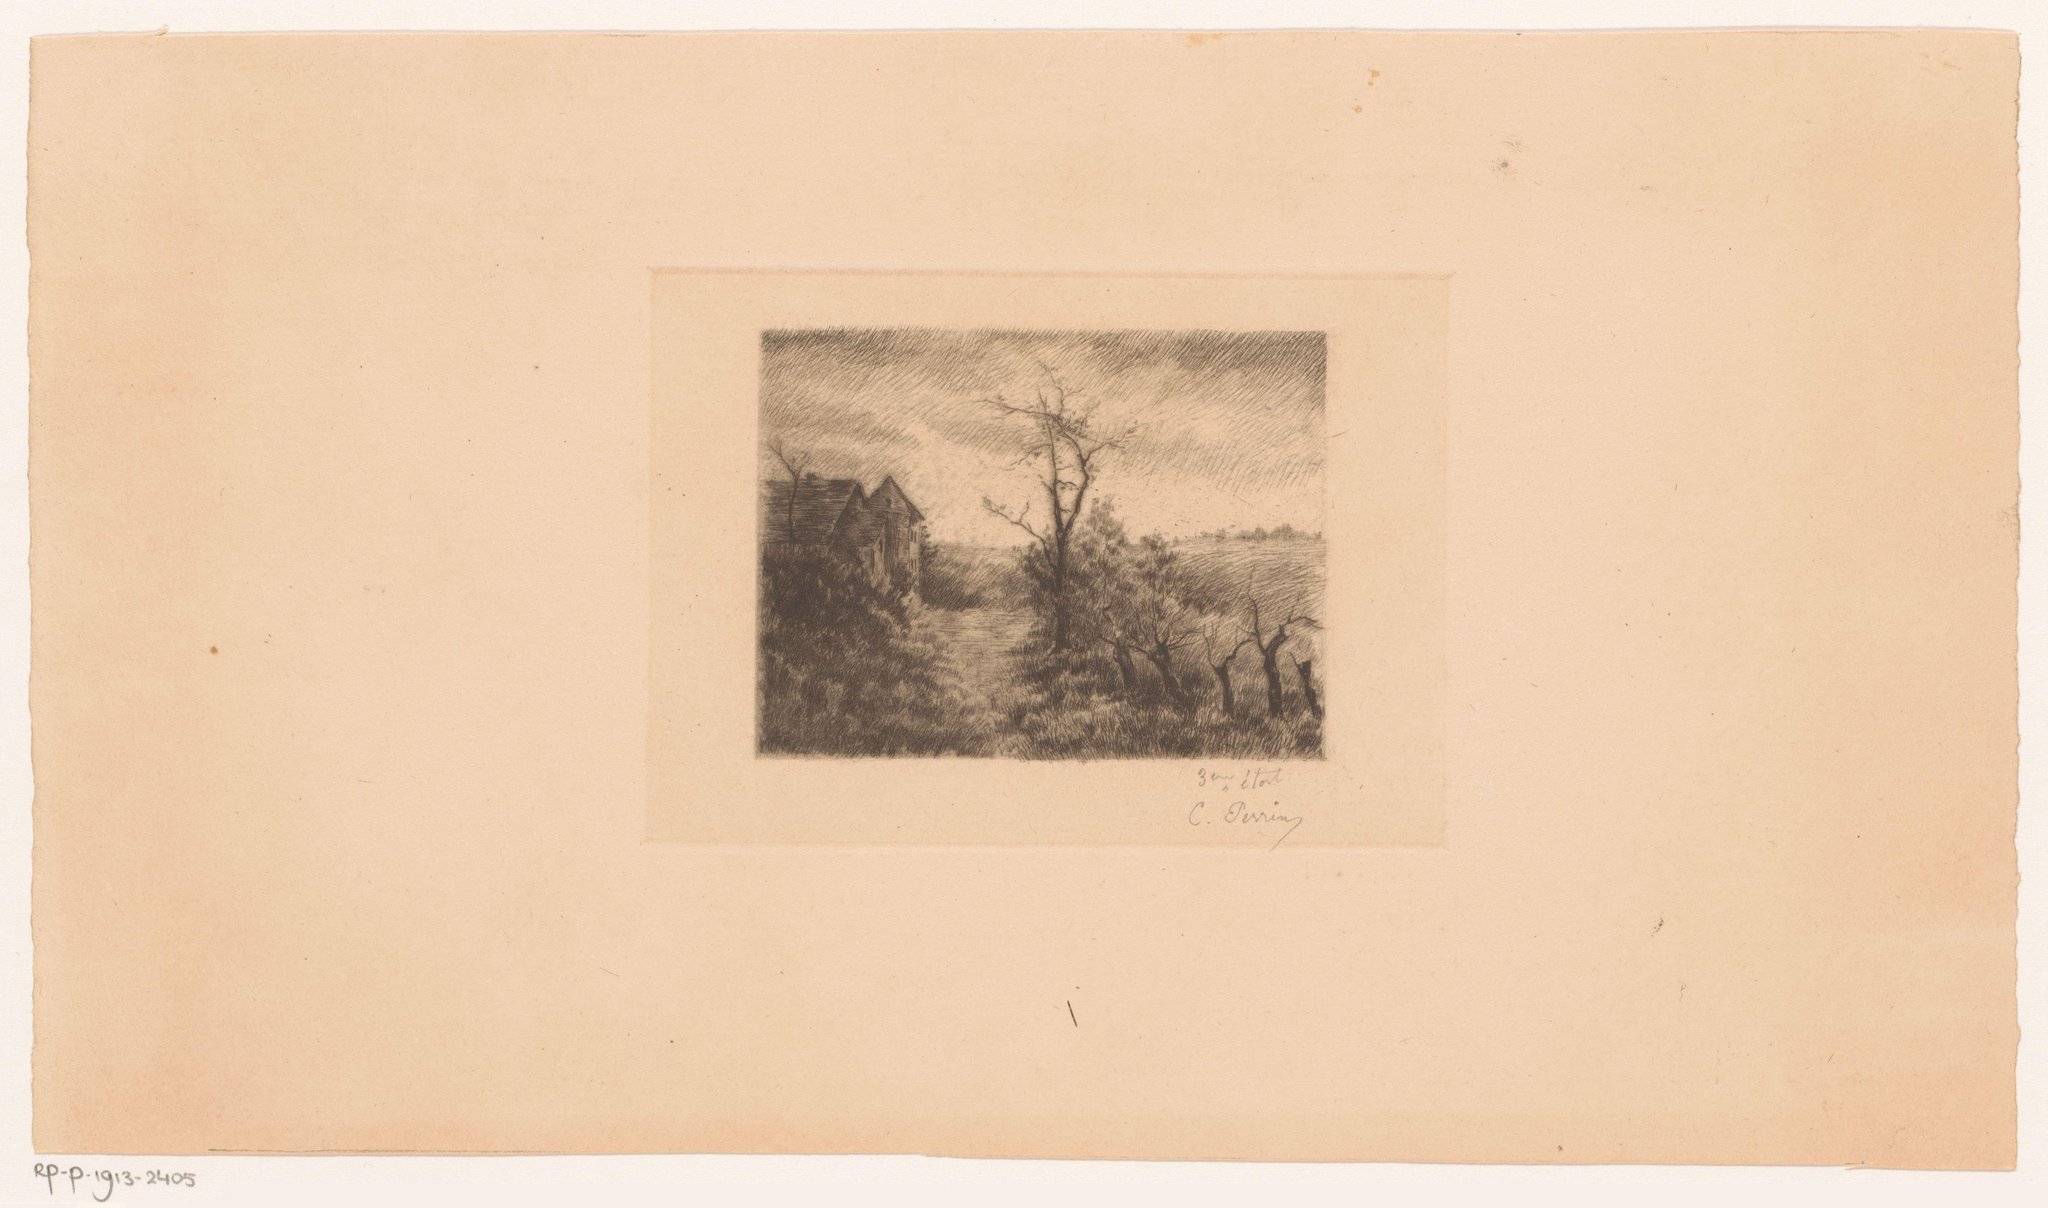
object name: print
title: Landschap met kale bomen bij een gebouw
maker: ch. perrin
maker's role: print maker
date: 1850-1913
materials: paper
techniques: drypoint, etching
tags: trees, landscapes in the temperate zone, farm or solitary house in landscape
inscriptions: annotation: ‘3em état’, collector's mark: Lugt 2228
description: Geboorte- en sterfdatum van de prentmaker zijn onbekend. Daarom is voor de bepaling van de rechten van dit object gebruik gemaakt van de verwervingsdatum Rijksmuseum Amsterdam.